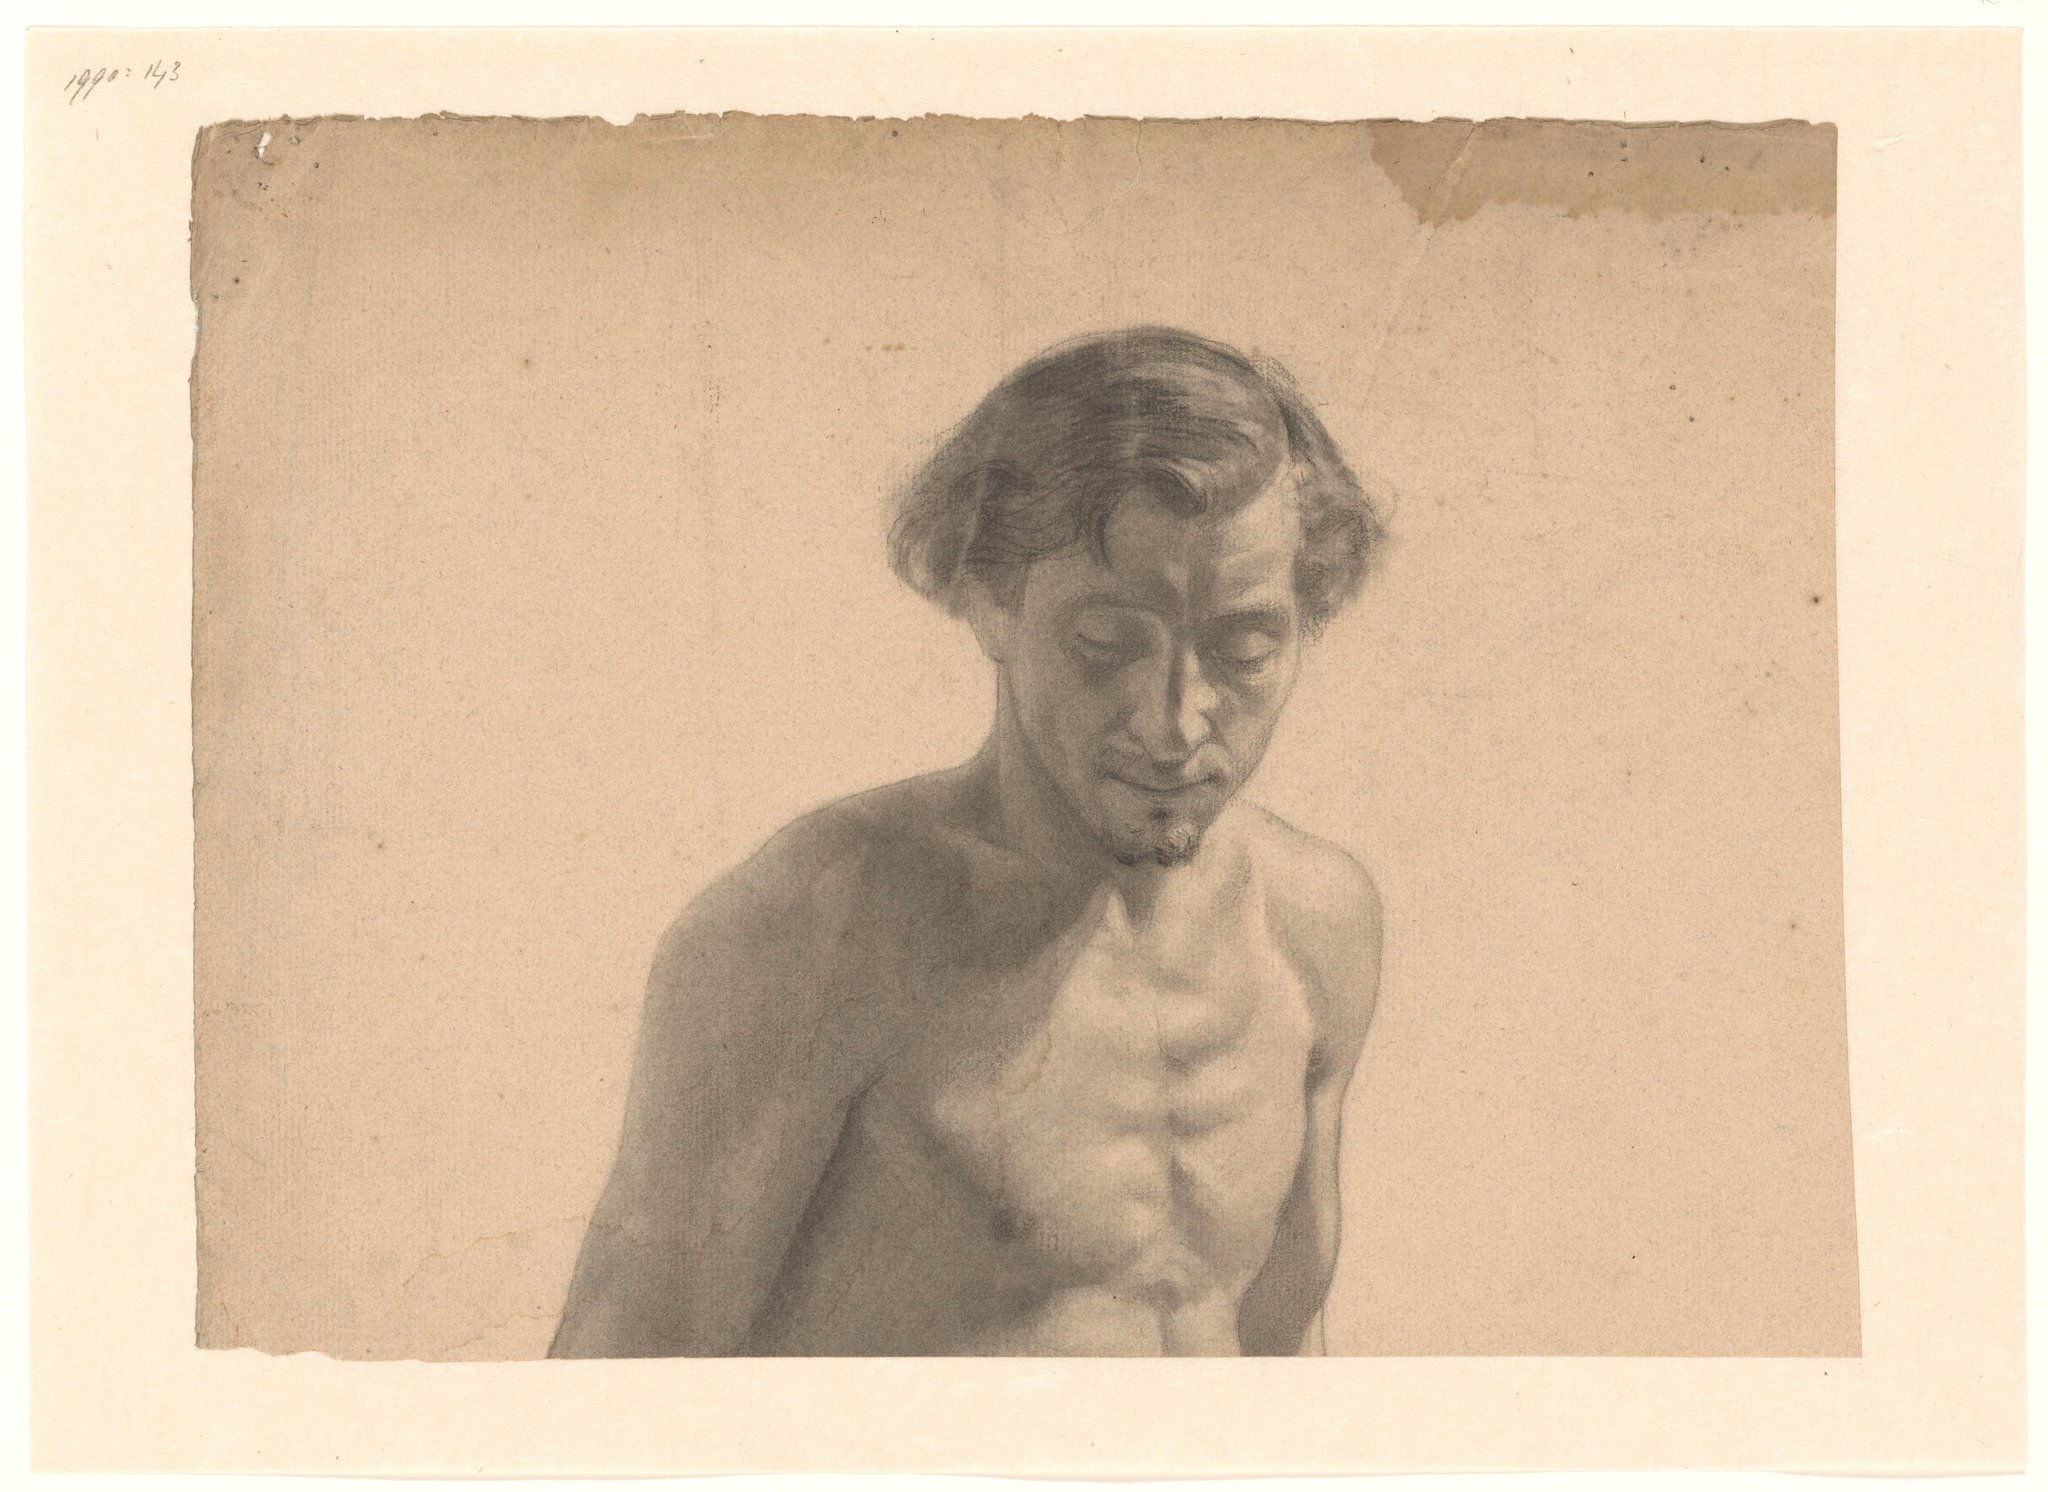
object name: drawing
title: Mannelijk naakt, ten halven lijve, neerziend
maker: johan braakensiek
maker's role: draughtsman, print maker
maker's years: 1858-1940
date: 1868-1940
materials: chalk, paper